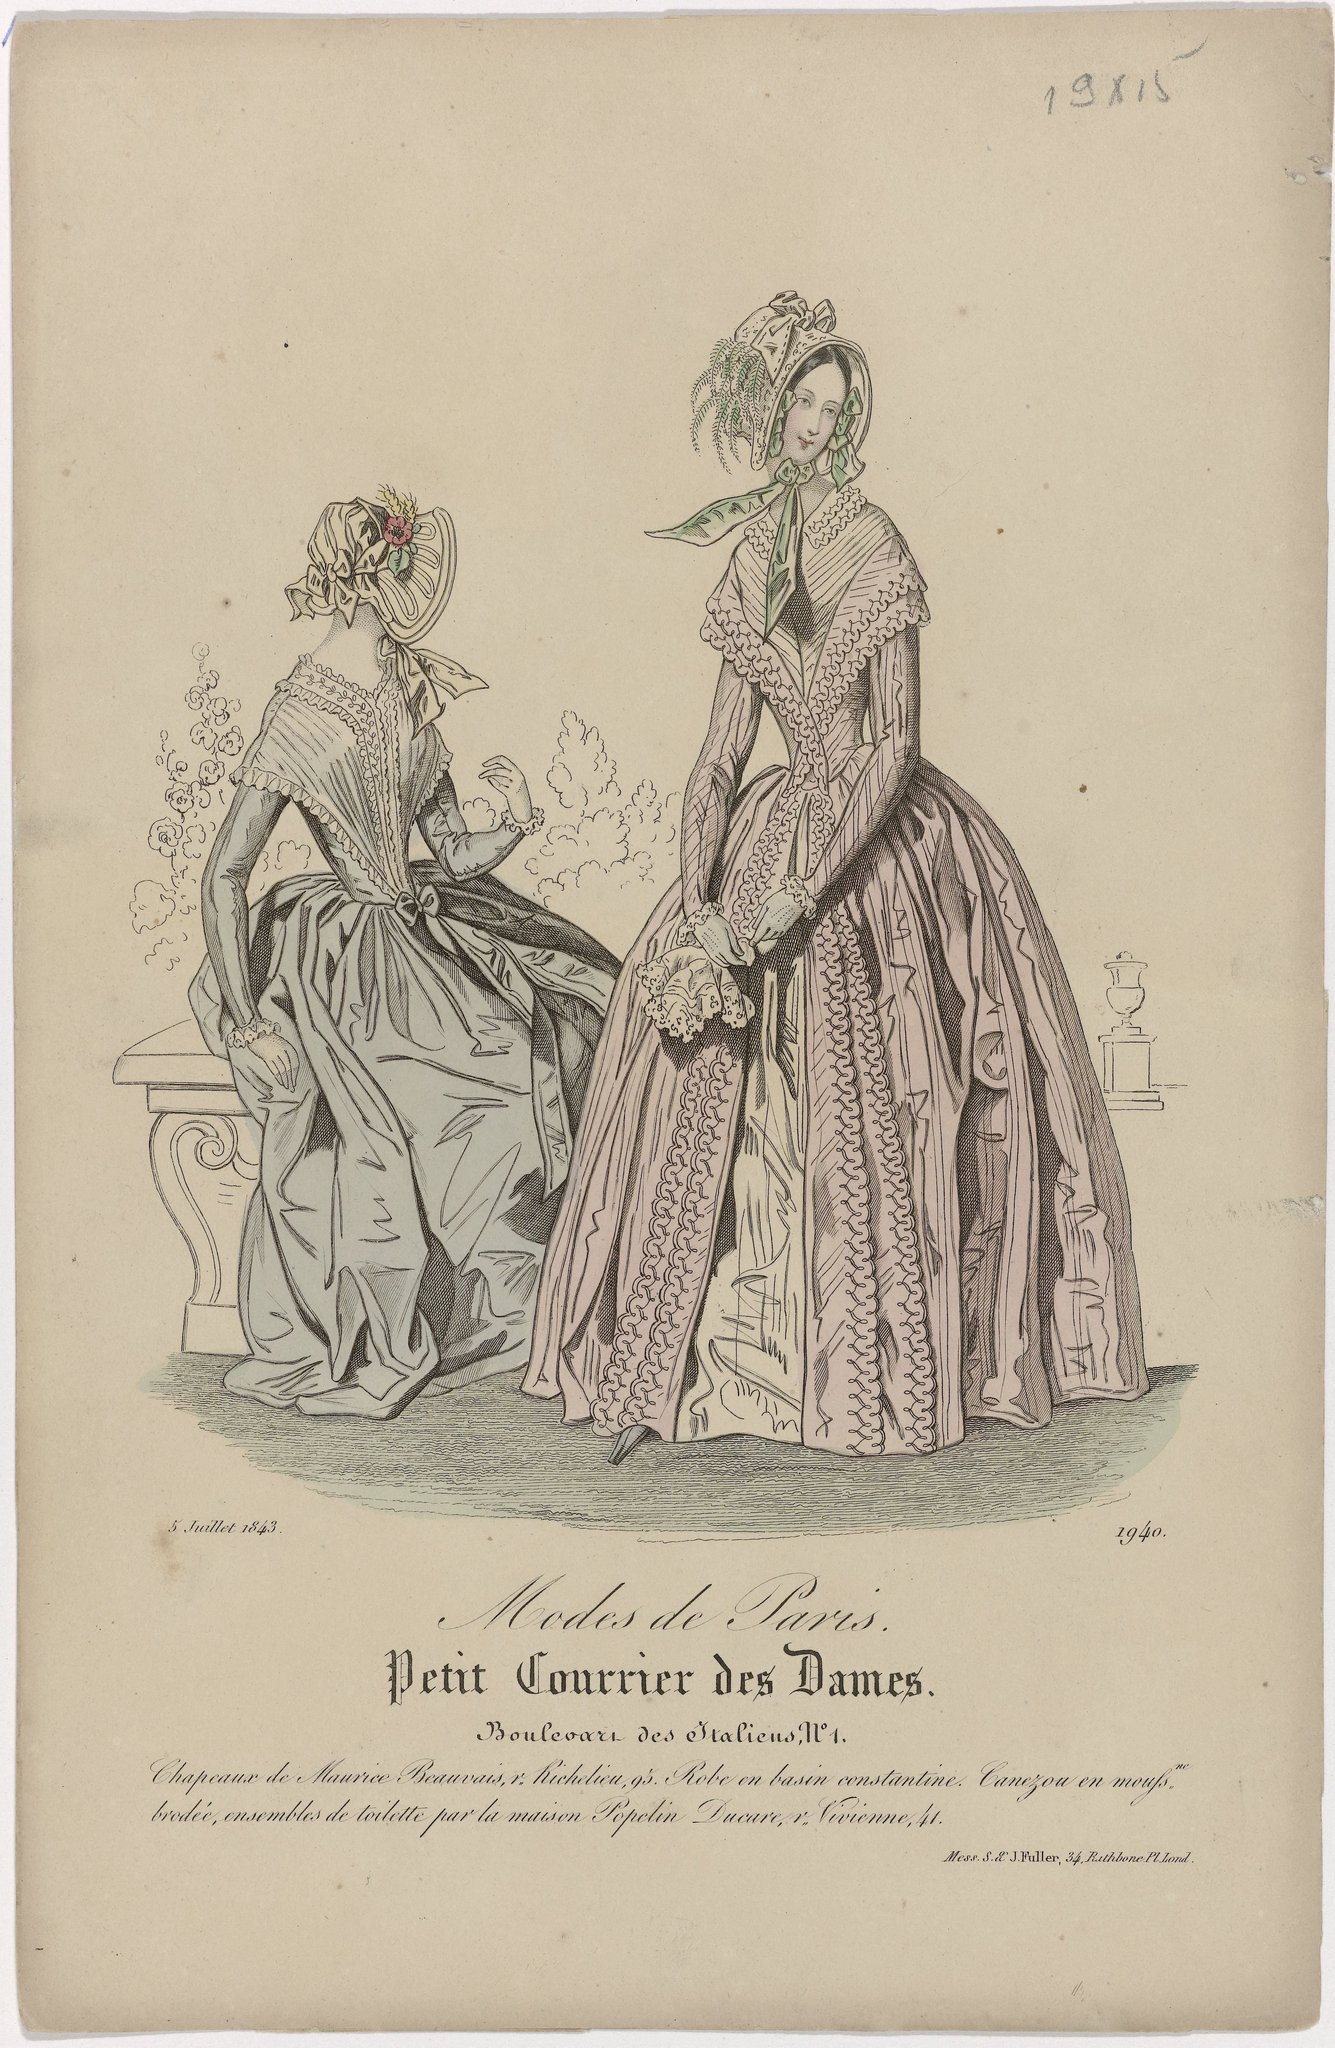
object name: fashion print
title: Petit Courrier des Dames, 5 jullet 1843, No. 1940 : Chapeaux de Maurice Beauvais (...)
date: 1843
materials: paper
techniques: engraving, hand coloring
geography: london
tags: handkerchief (+ women's clothes), fashion plates, head-gear: hat (+ women's clothes), dress, gown (+ women's clothes)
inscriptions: caption: ‘Chapeaux de Maurice Beauvais, r"Richelieu, 95. Robe en basin constantine. Canezou en mouss"ne brodée, ensembles de toilette par la maison Popelin Ducare, r"Vivienne, 41.’, address: ‘Boulevard des Italiens, No. 1. / Mess. S.& J.Fuller, 34, Rathbone Pl. Lond.’, title: ‘Modes de Paris.’, title: ‘Petit Courrier des Dames.’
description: Hoeden van Maurice Beauvais. Japon van gestreepte 'constantine'. 'Canezou' van geborduurde mousseline, 'ensembles de toilette' door de firma Popelin Ducare. Verdere accessoires: handschoenen, zakdoek, schoen met vierkante neus. Prent uit het modetijdschrift Petit Courrier des Dames (1821-1868).